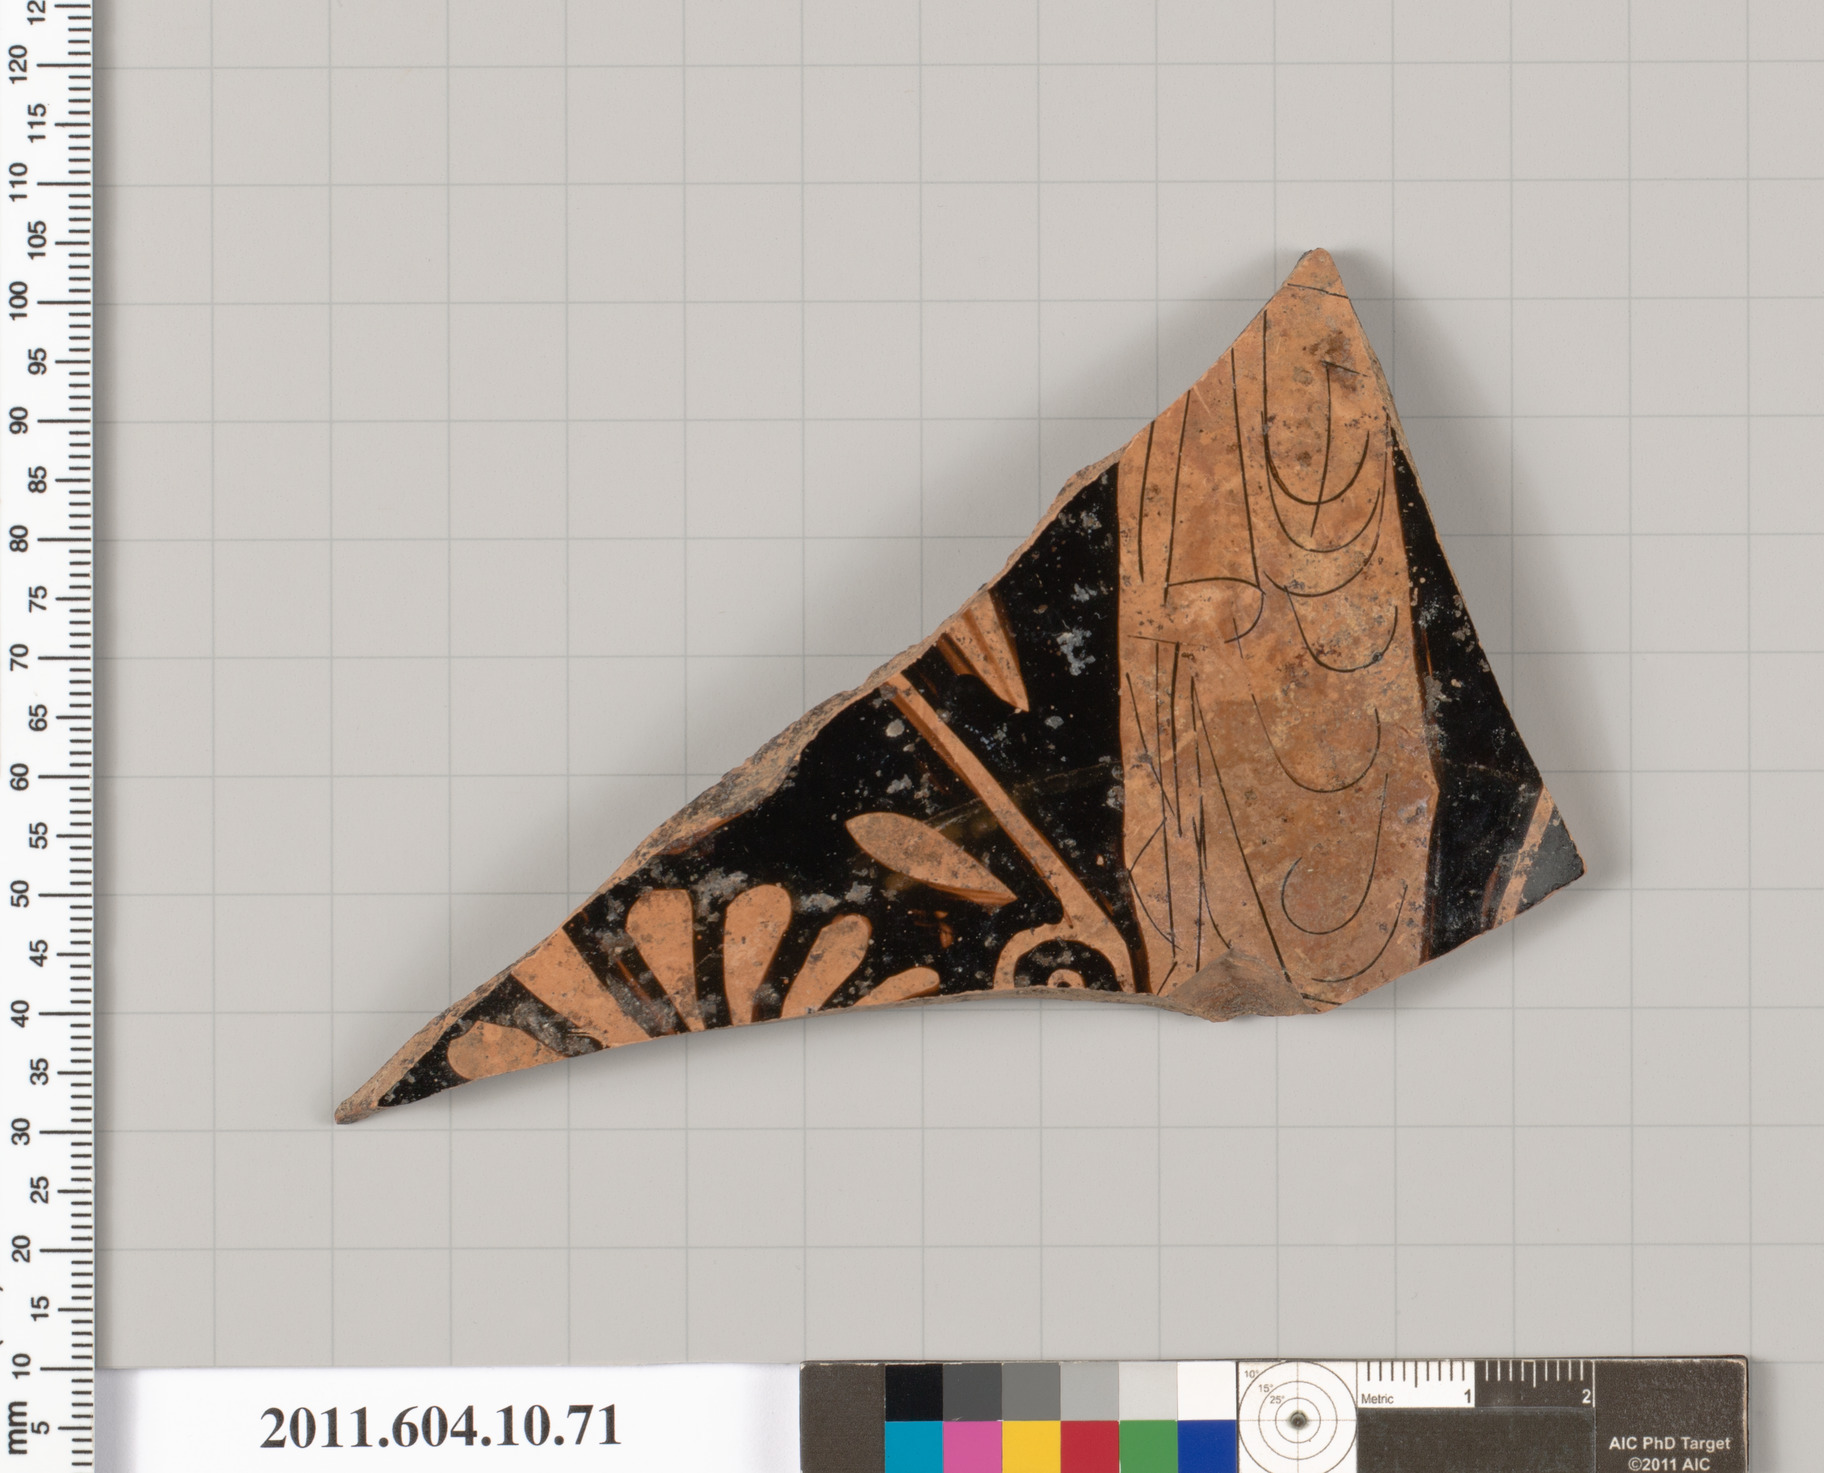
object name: kylix fragment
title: Terracotta fragment of a kylix (drinking cup)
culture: etruscan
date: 334-301 BCE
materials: terracotta